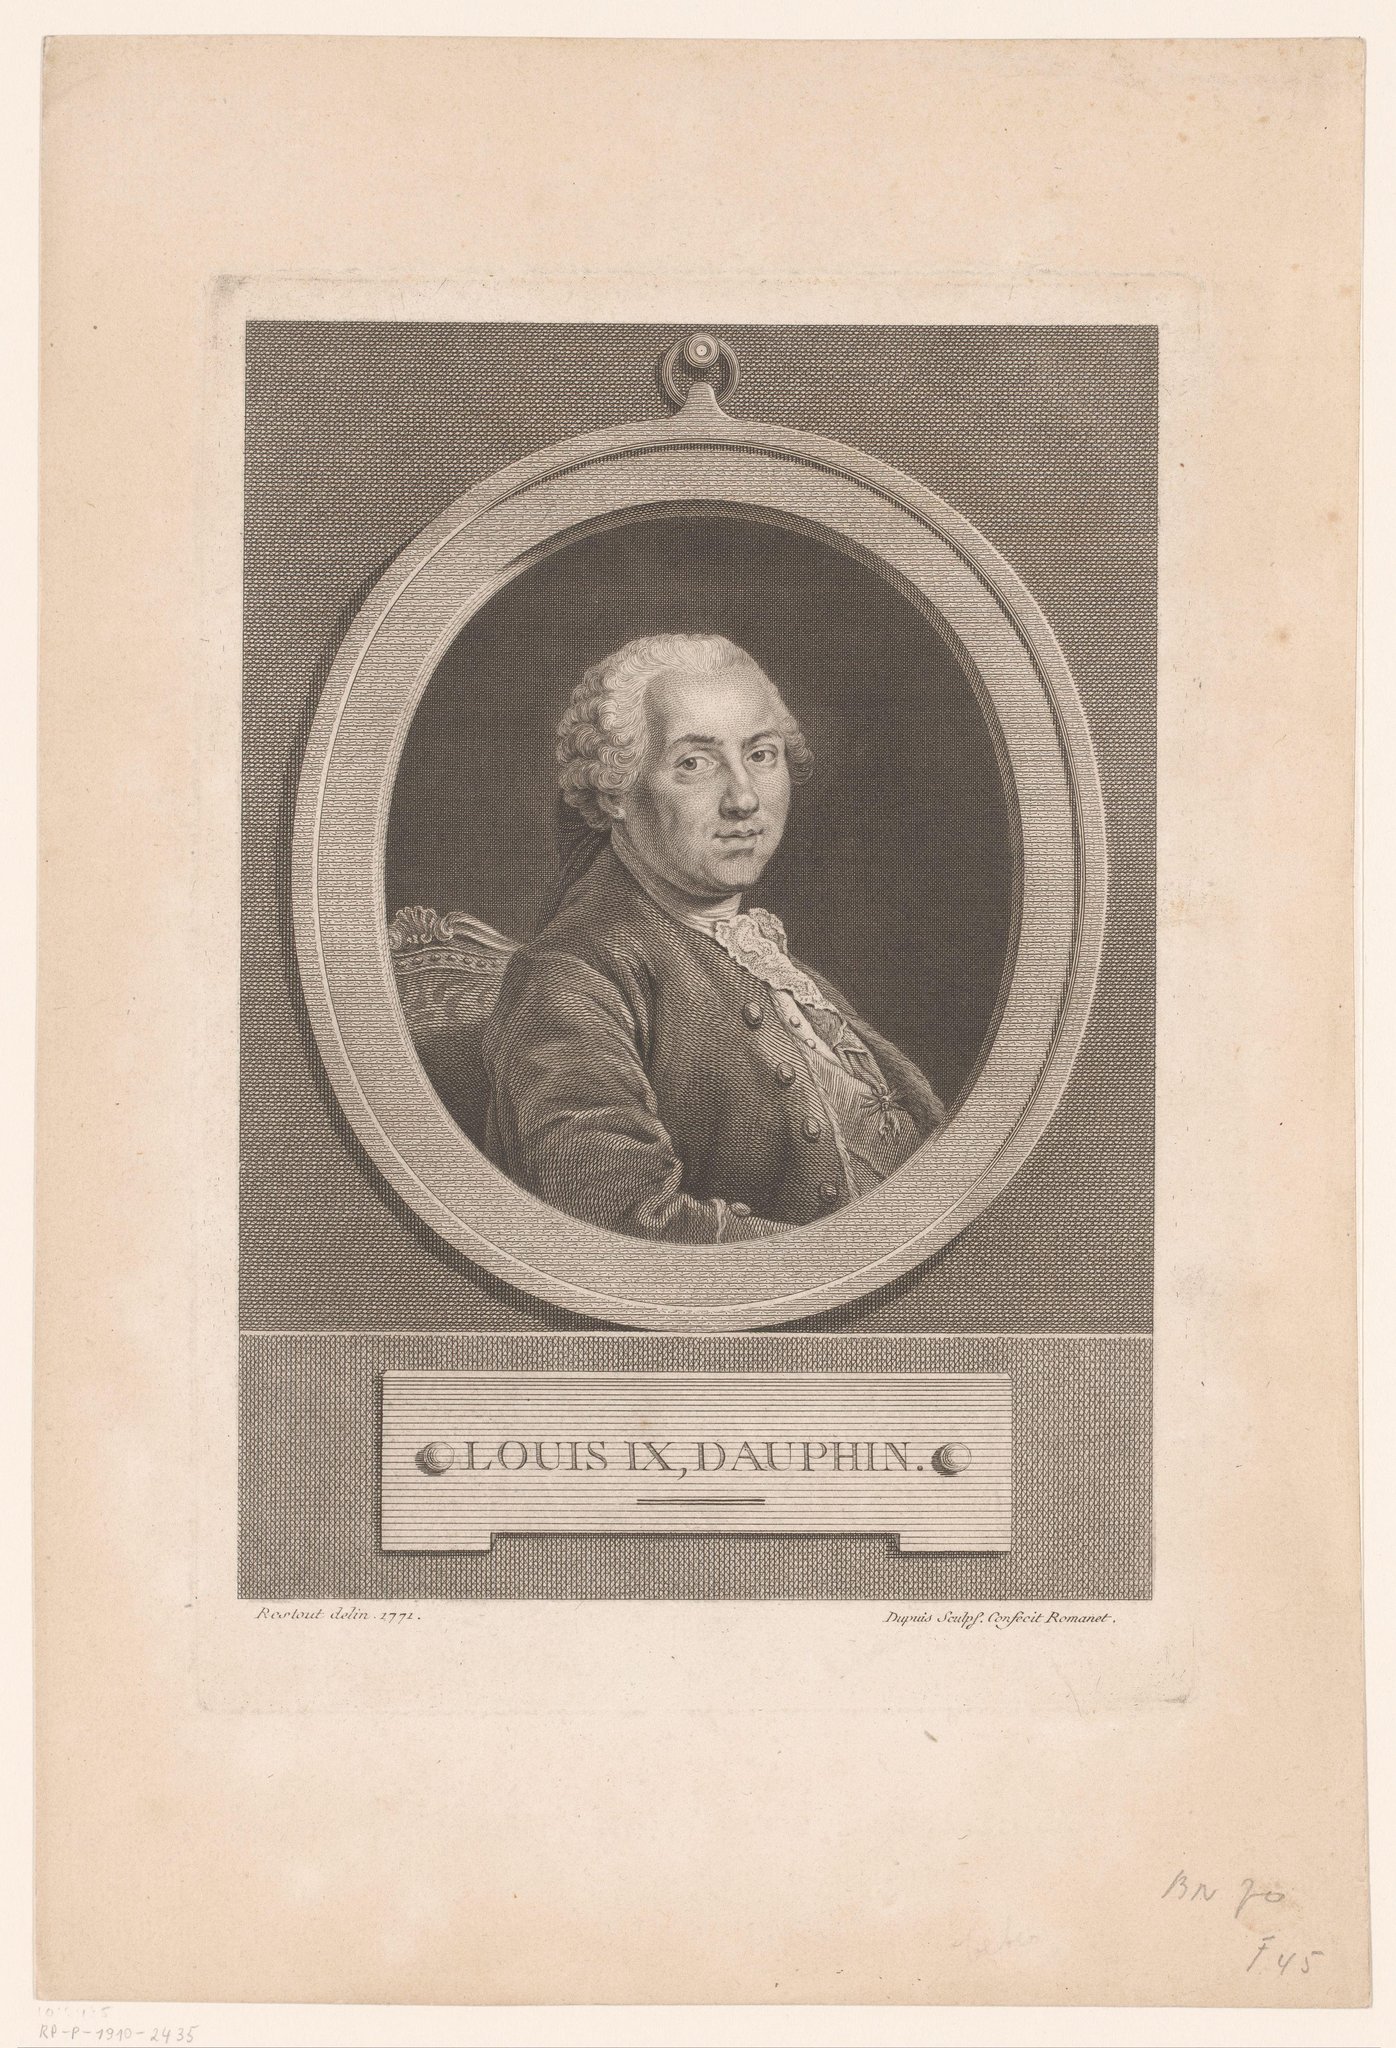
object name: print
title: Louis XIII. dit le Juste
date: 1755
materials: paper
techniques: engraving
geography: france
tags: lodewijk xiii (koning van frankrijk), ornament ~ medallion, historical persons, ruler, sovereign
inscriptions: collector's mark: Lugt 2228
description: Prent uit: Dreux du Radier, Jean-François. L'Europe illustré, contenant l'histoire abregée des souverains, des princes, des prélats, des ministres, (...) en Europe: dans le XVe. siècle compris, jusqu'à présent. Parijs: Michel Odieuvre en Jean-Luc Nyon, 1755, dl. 1.